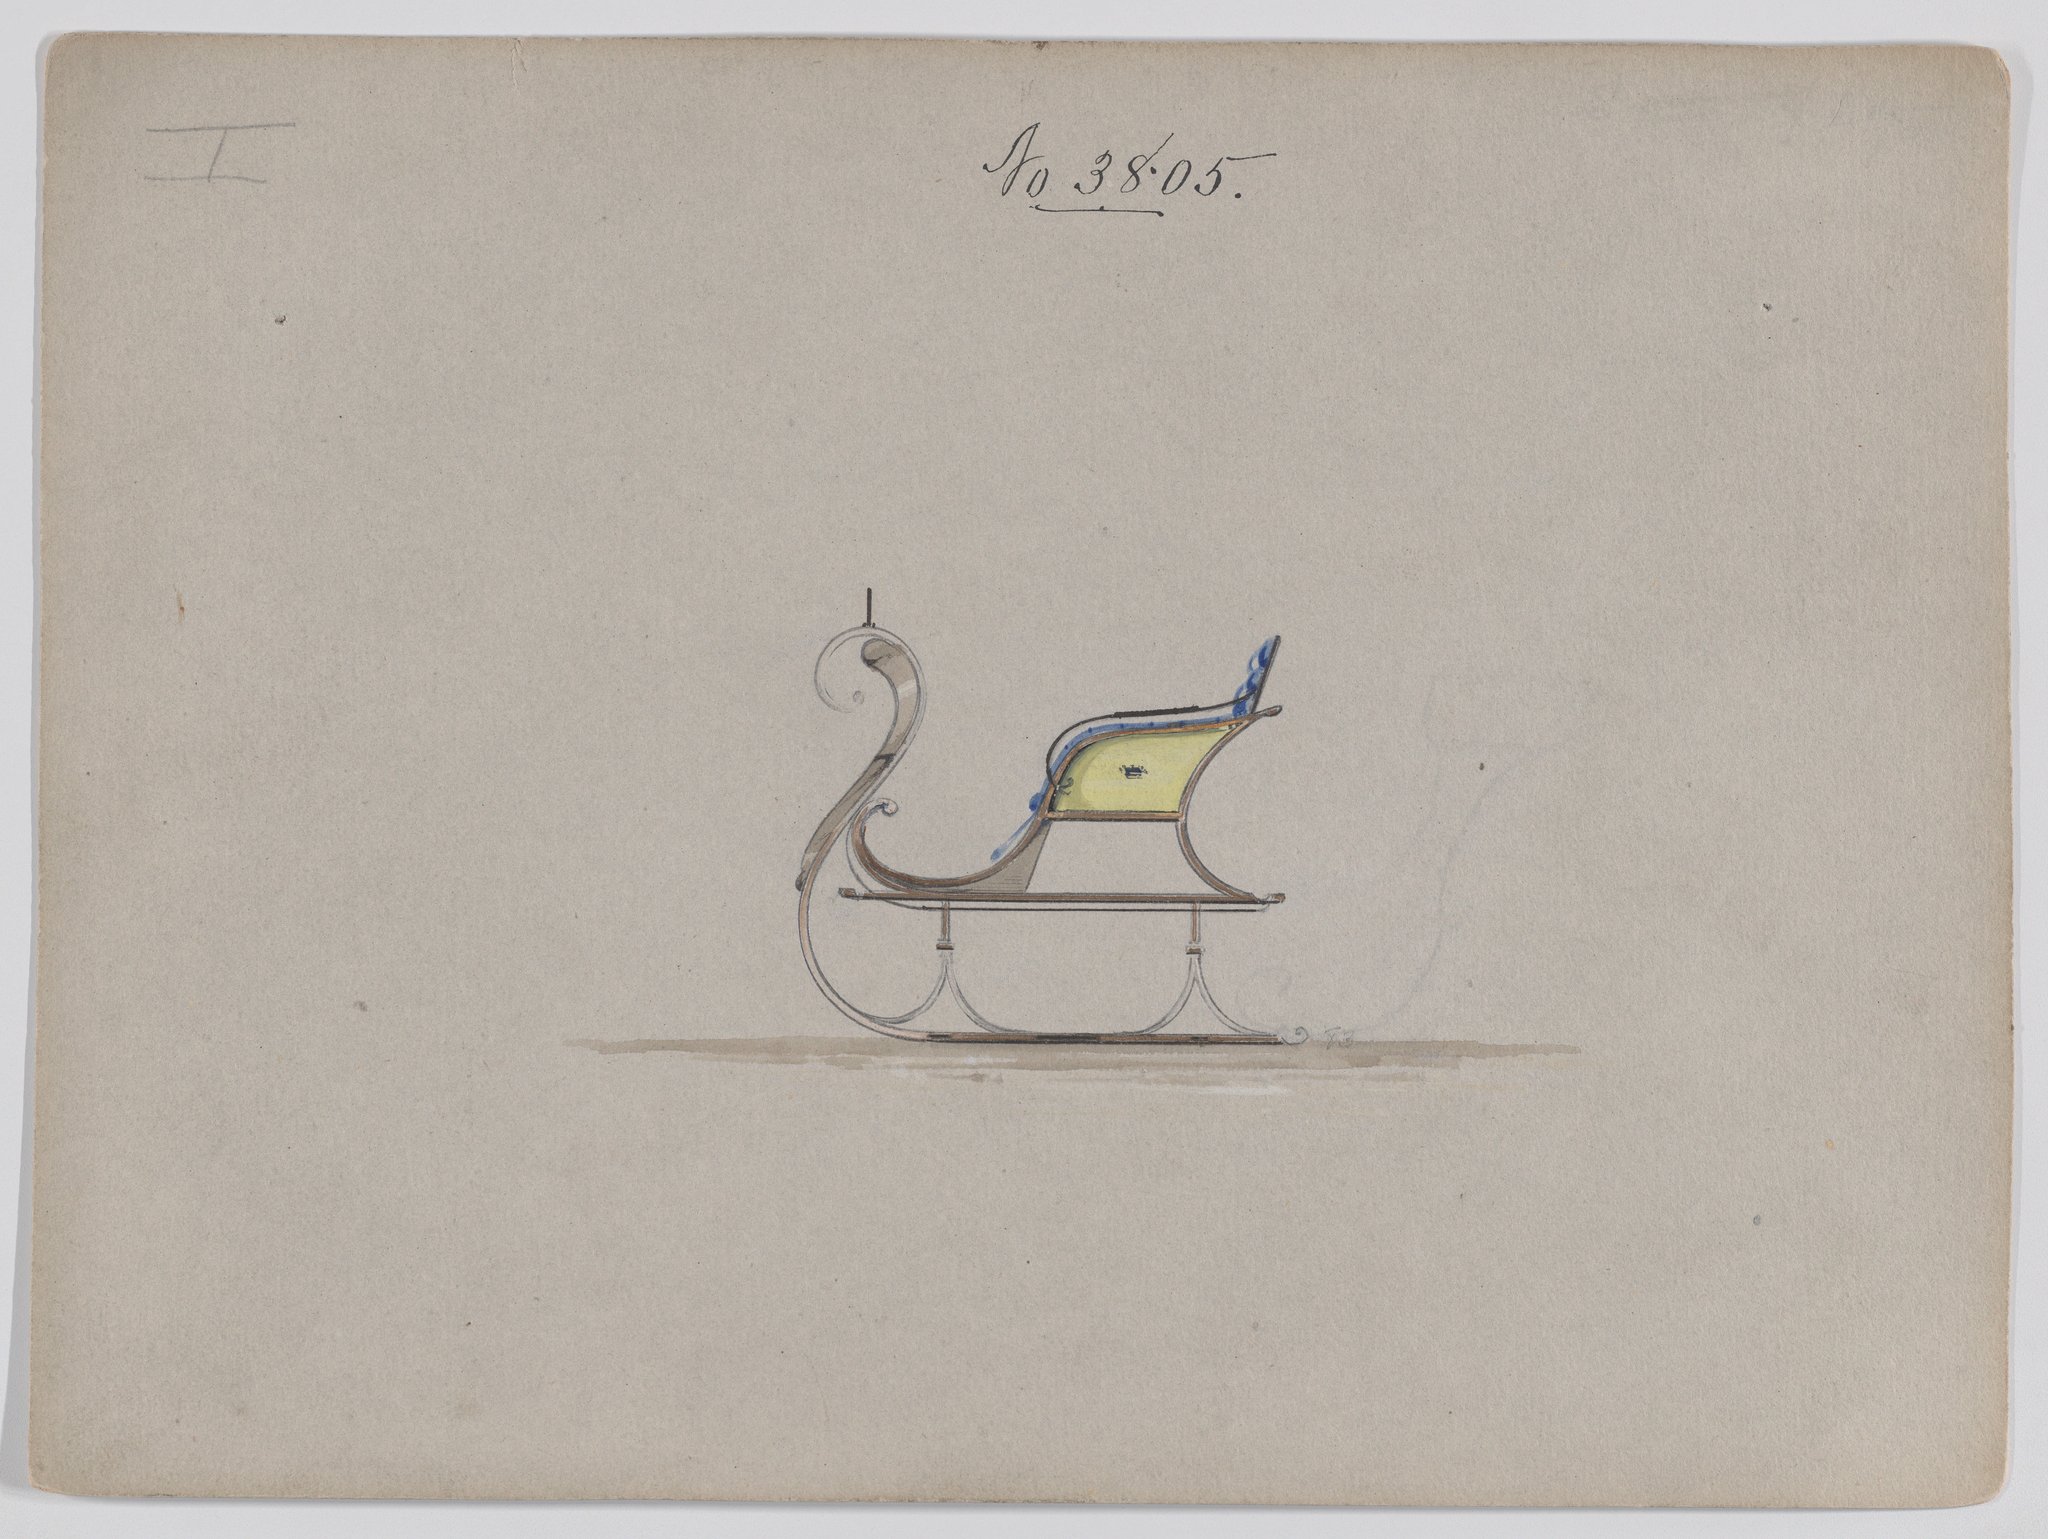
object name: drawing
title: Open Panel Sleigh # 3805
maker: brewster & co.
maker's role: manufacturer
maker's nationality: american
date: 1883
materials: gouache, ink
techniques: pen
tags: sleighs